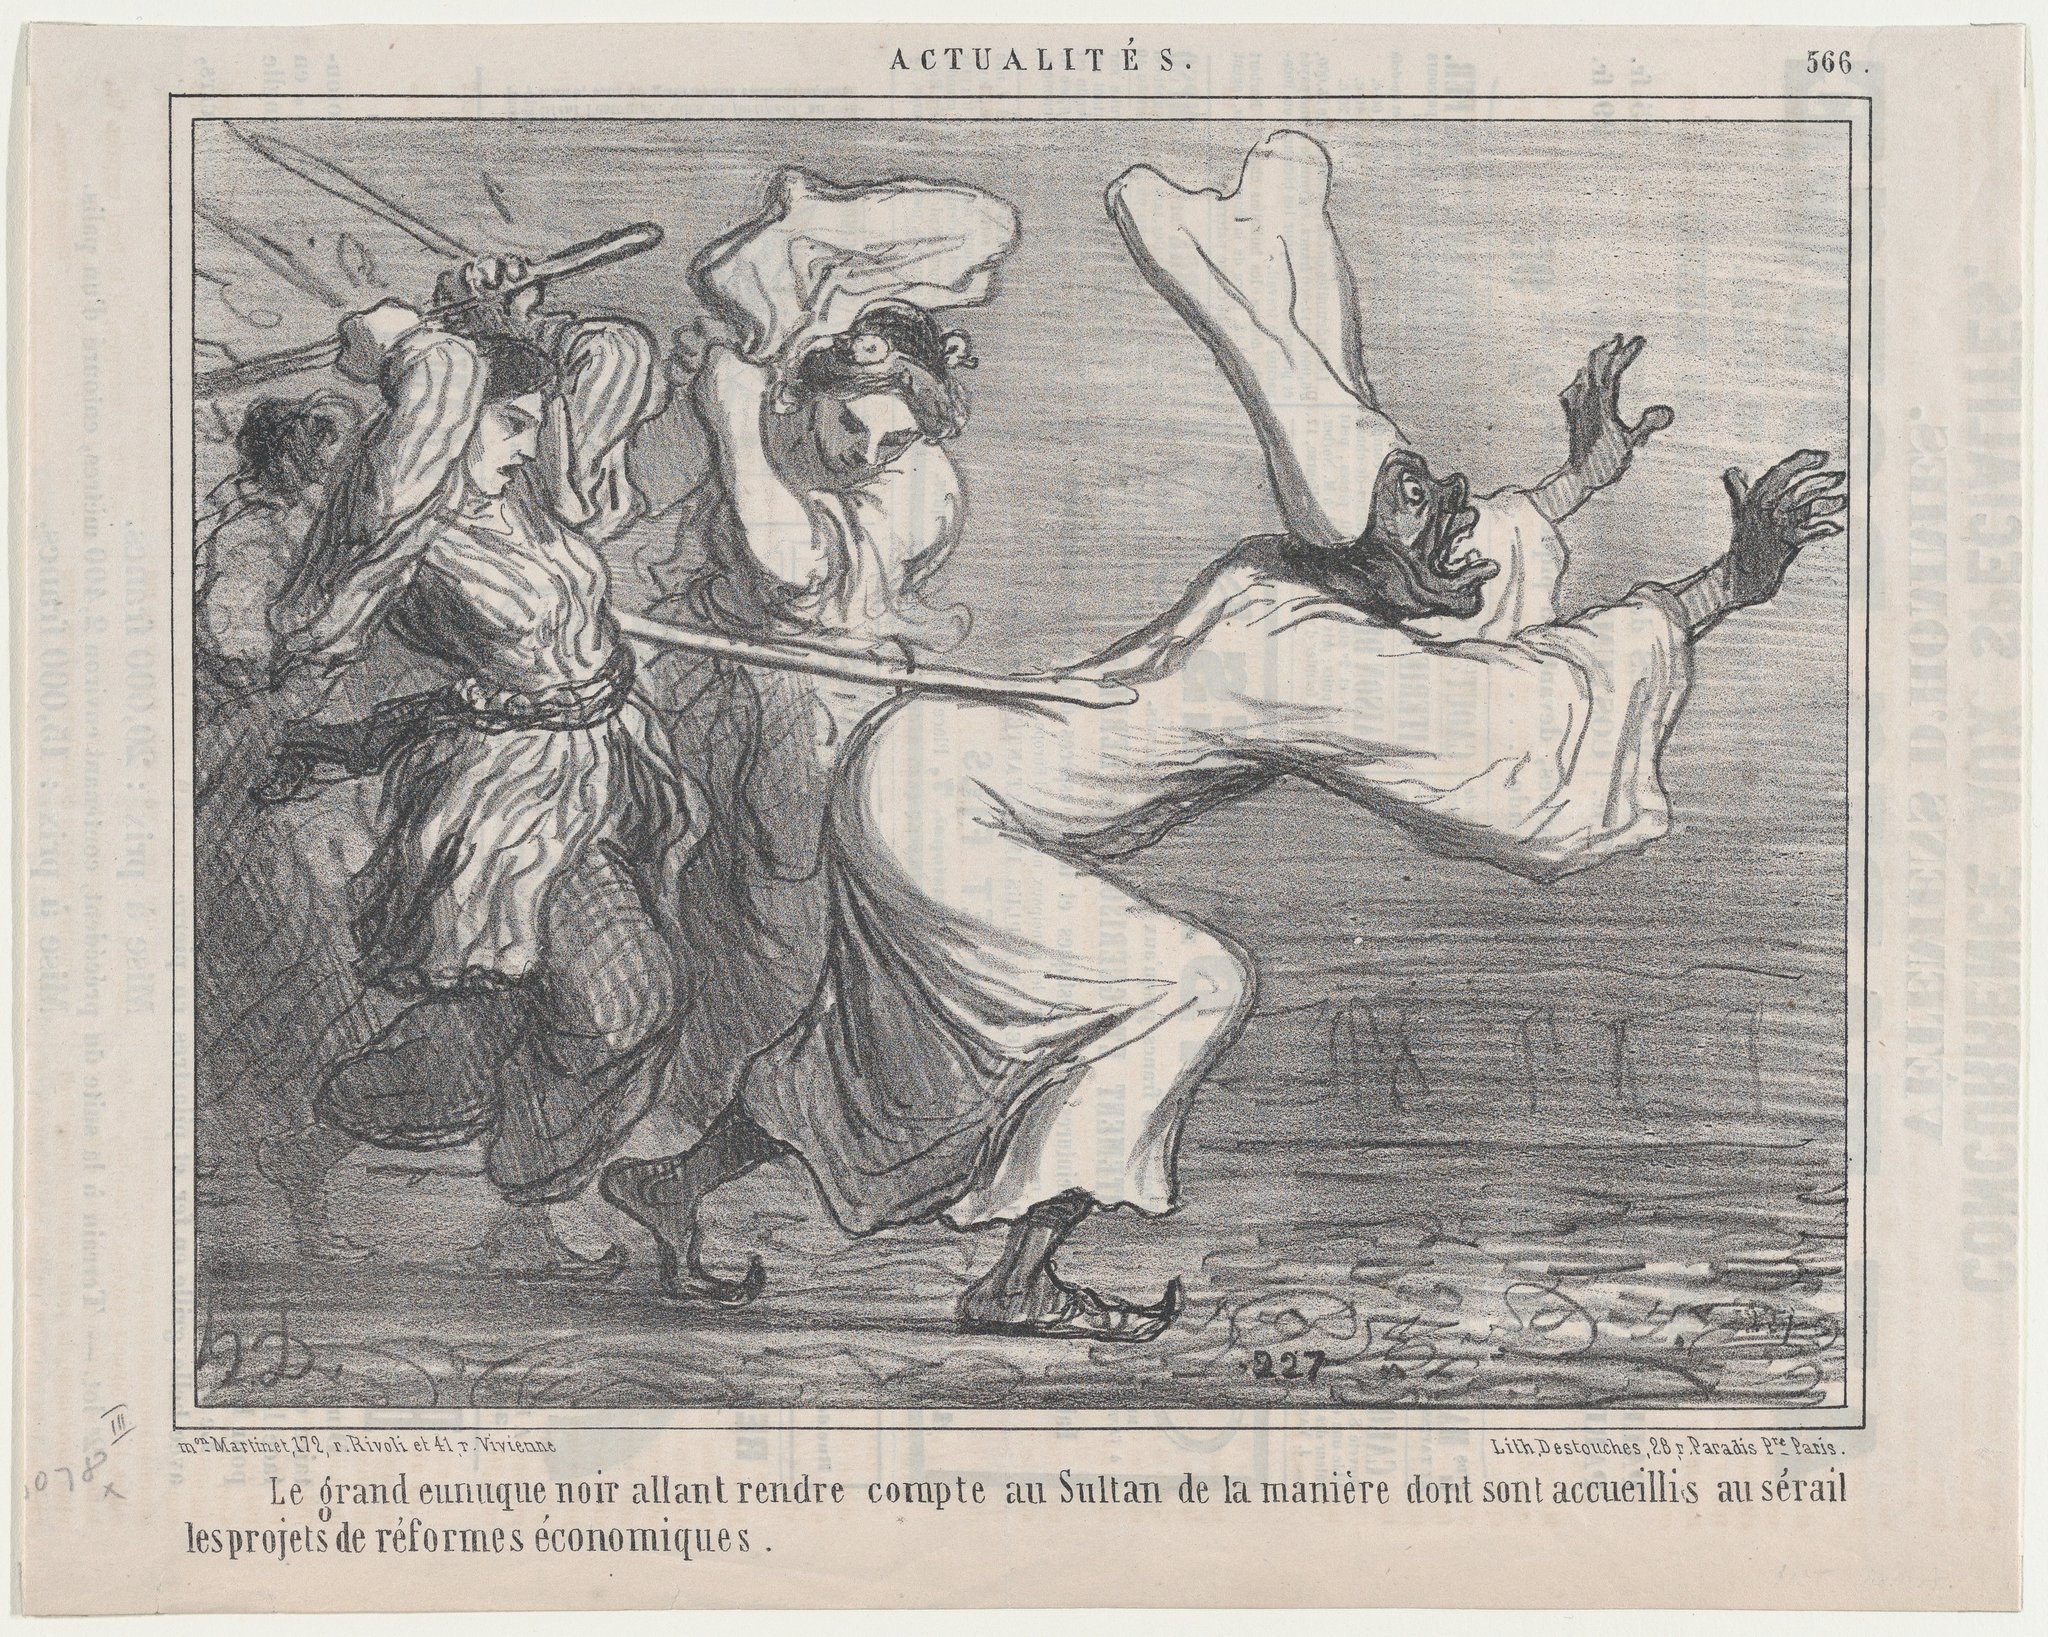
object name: print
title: Le grand eunuque noir allant rendre compte au Sultan..., from Actualités, published in Le Charivari, September 18, 1858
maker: honoré daumier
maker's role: artist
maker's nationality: french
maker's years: 1808-1879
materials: paper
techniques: lithograph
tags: men,women